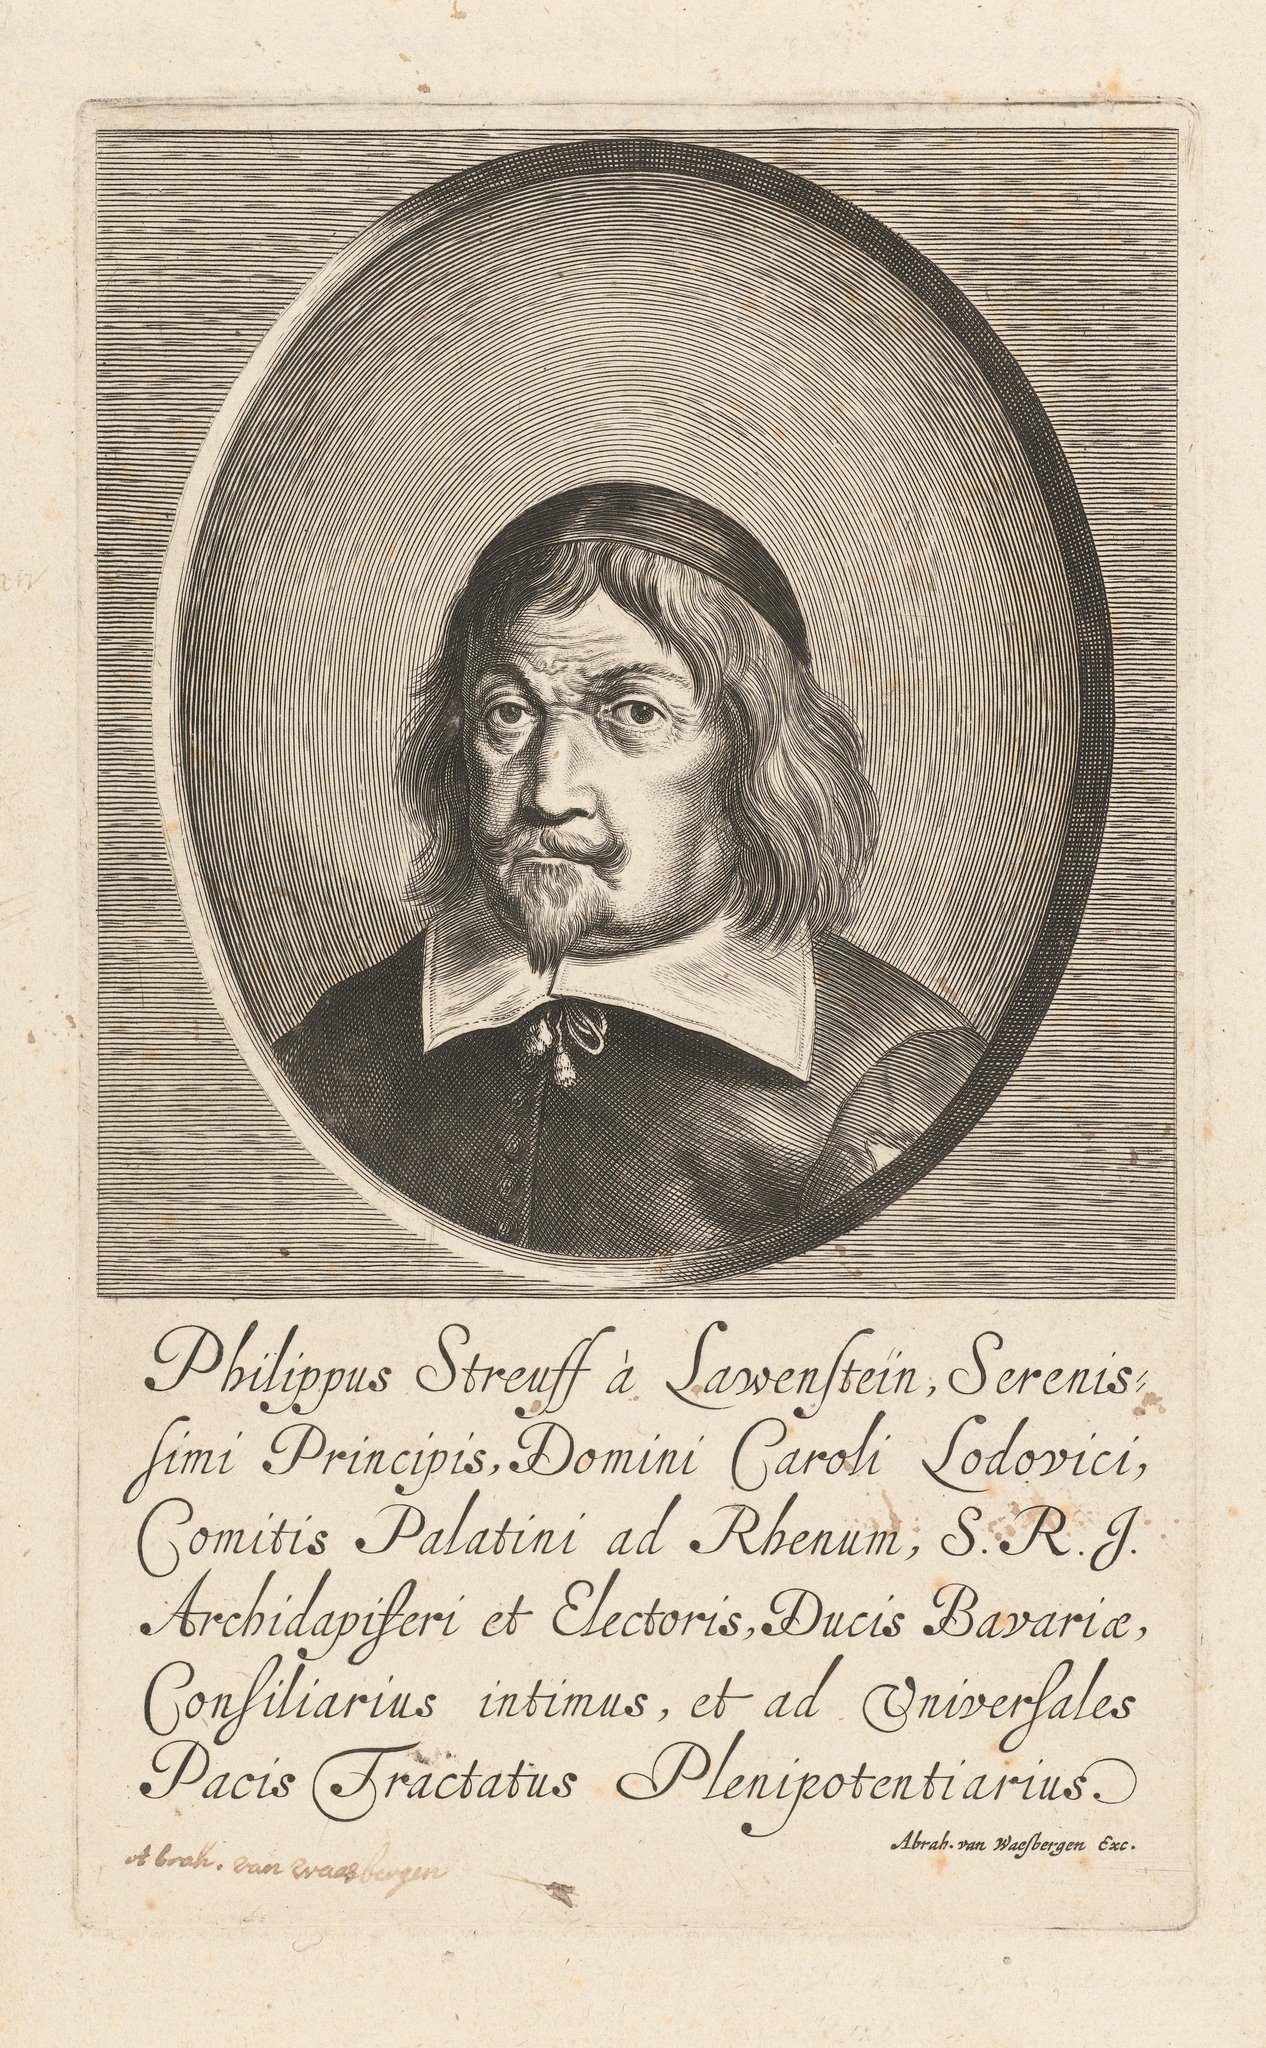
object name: print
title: Philippus Streuff a (...) pacis tractatus plenipotentiarius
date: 1623-1660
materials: paper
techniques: engraving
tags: lahr, philipp streiff von lauenstein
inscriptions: collector's mark: Lugt 240